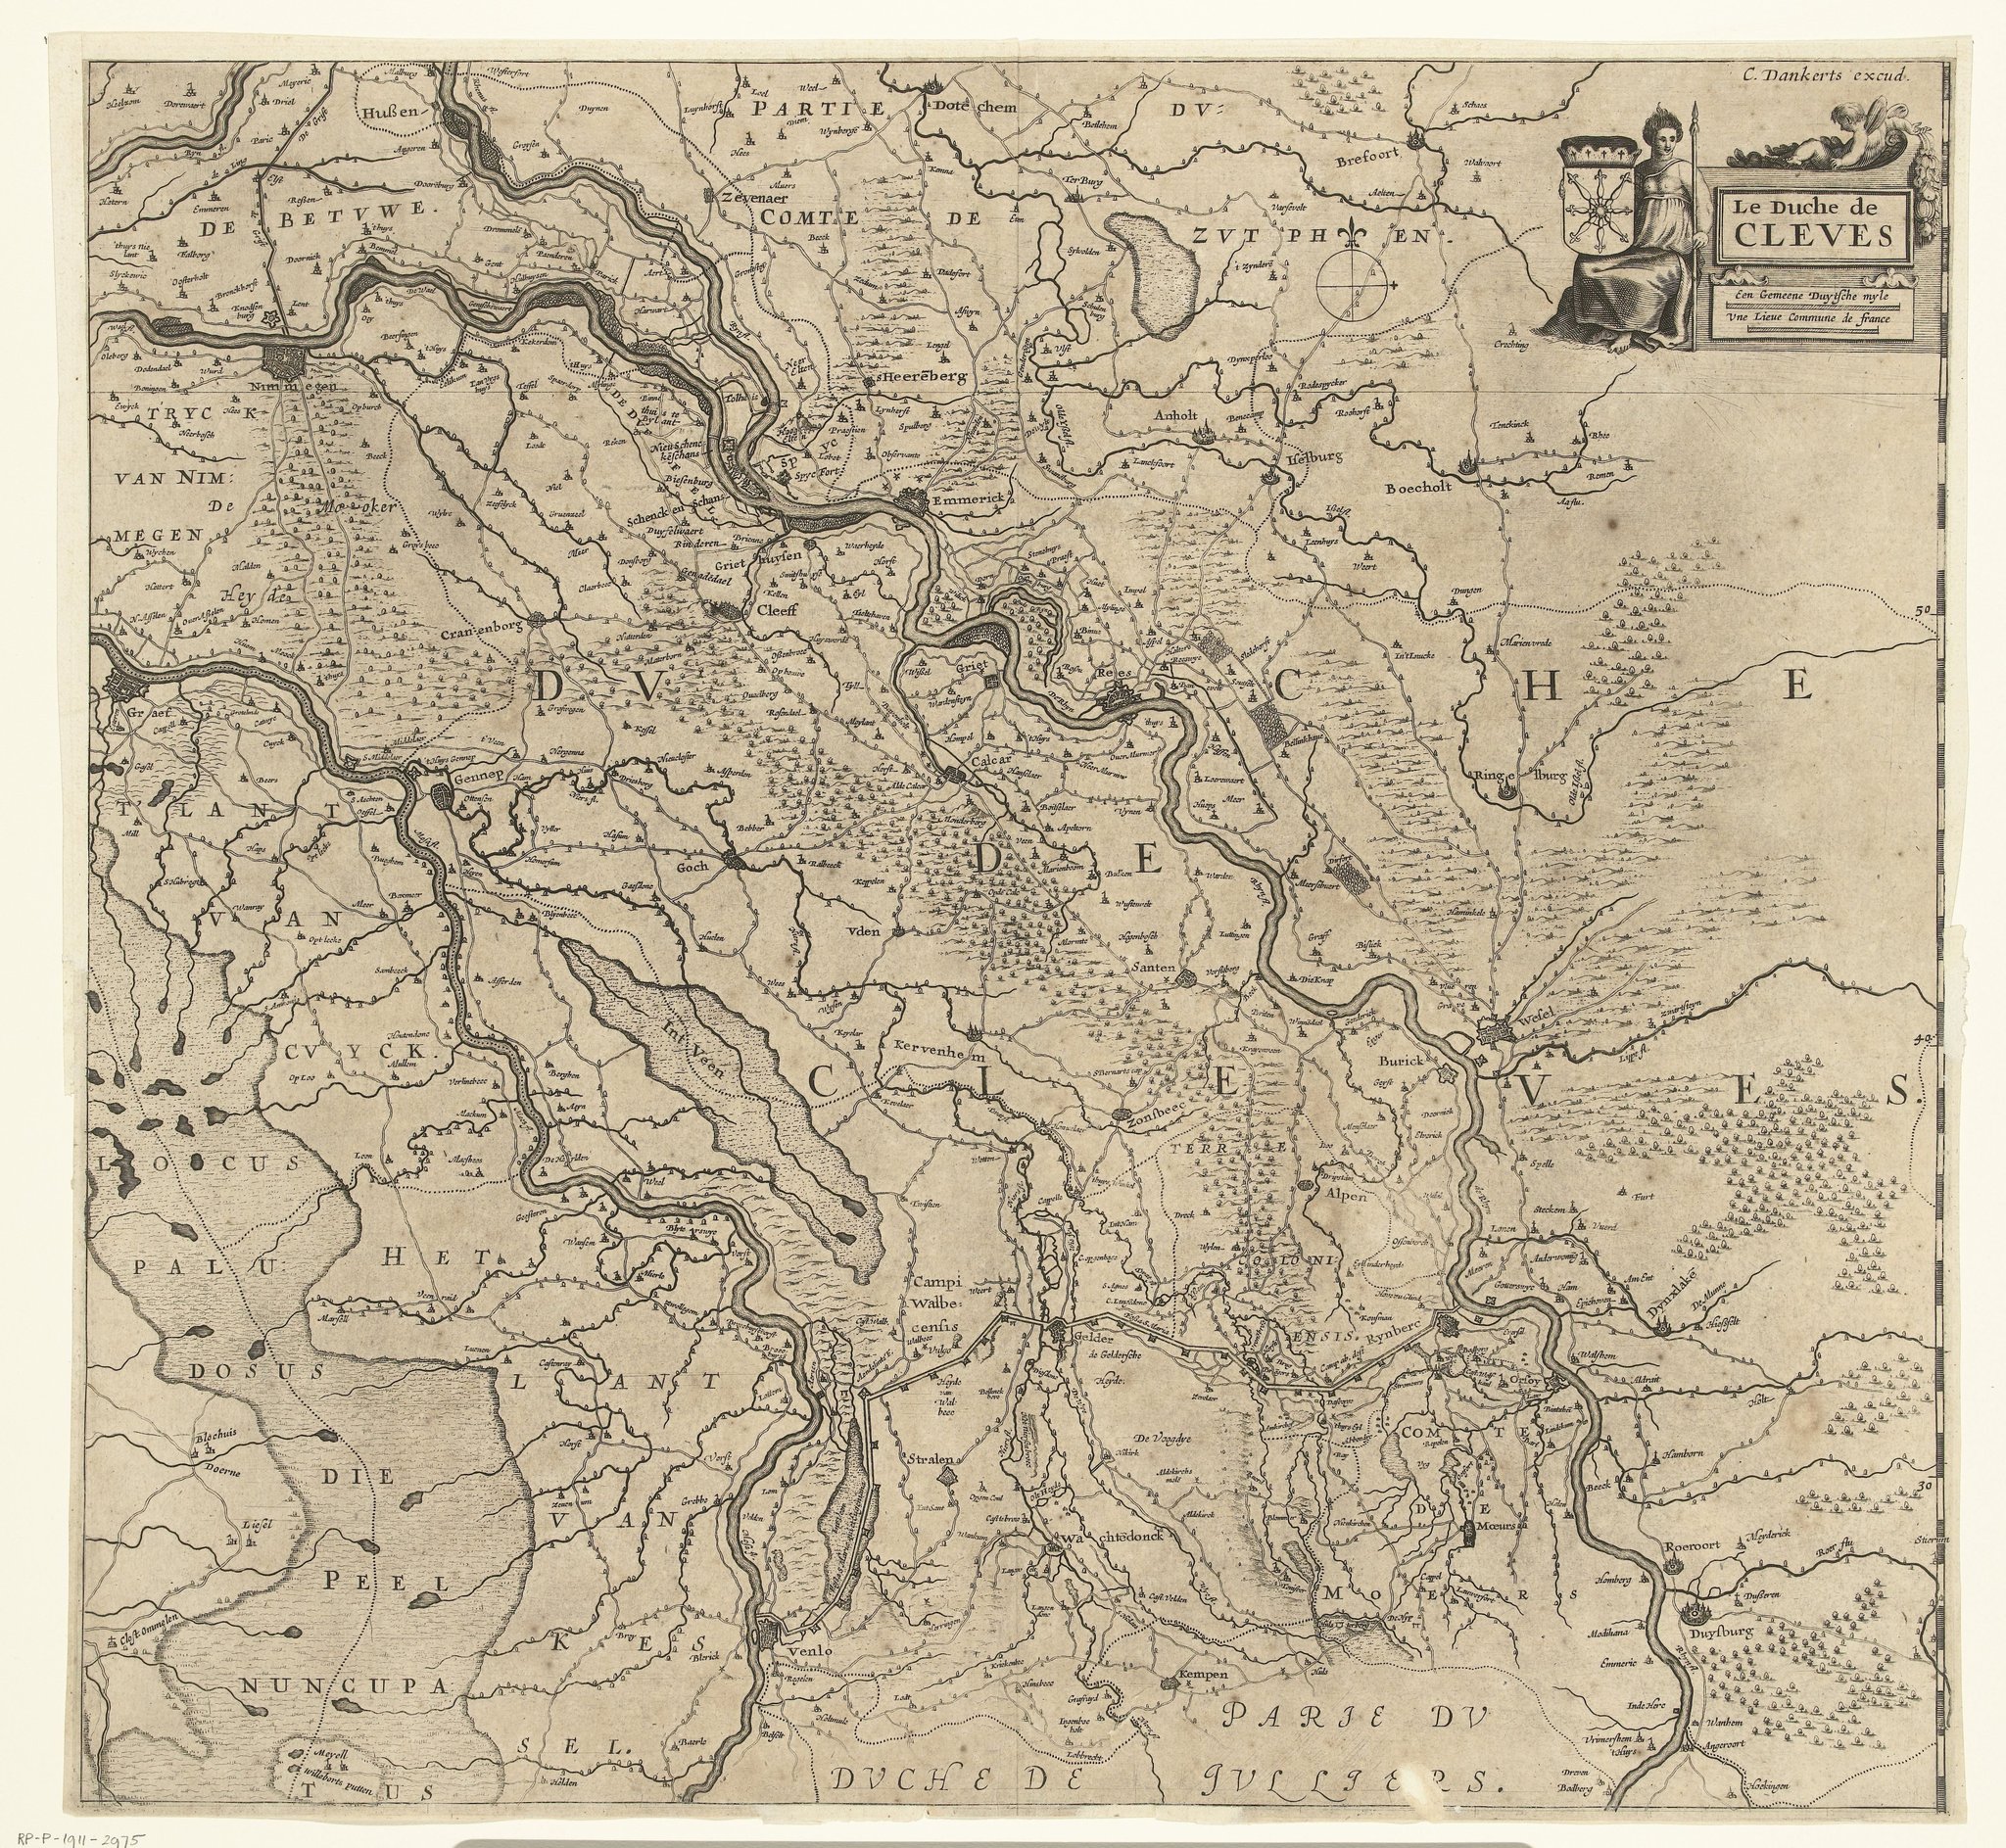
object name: print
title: Le Duche de Cleves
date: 1600-1699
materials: paper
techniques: engraving, etching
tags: maps of separate countries or regions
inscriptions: collector's mark: Lugt 2228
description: Kaart van Hertogdom Kleef met de vele plaatsen gelegen in het stroomgebied van de Rijn maar ook steden en dorpen bij de Maas tot aan Venlo. Rechtsboven cartouche met titel en meetlat geflankeerd door zittende vrouw met speer en wapenschild.